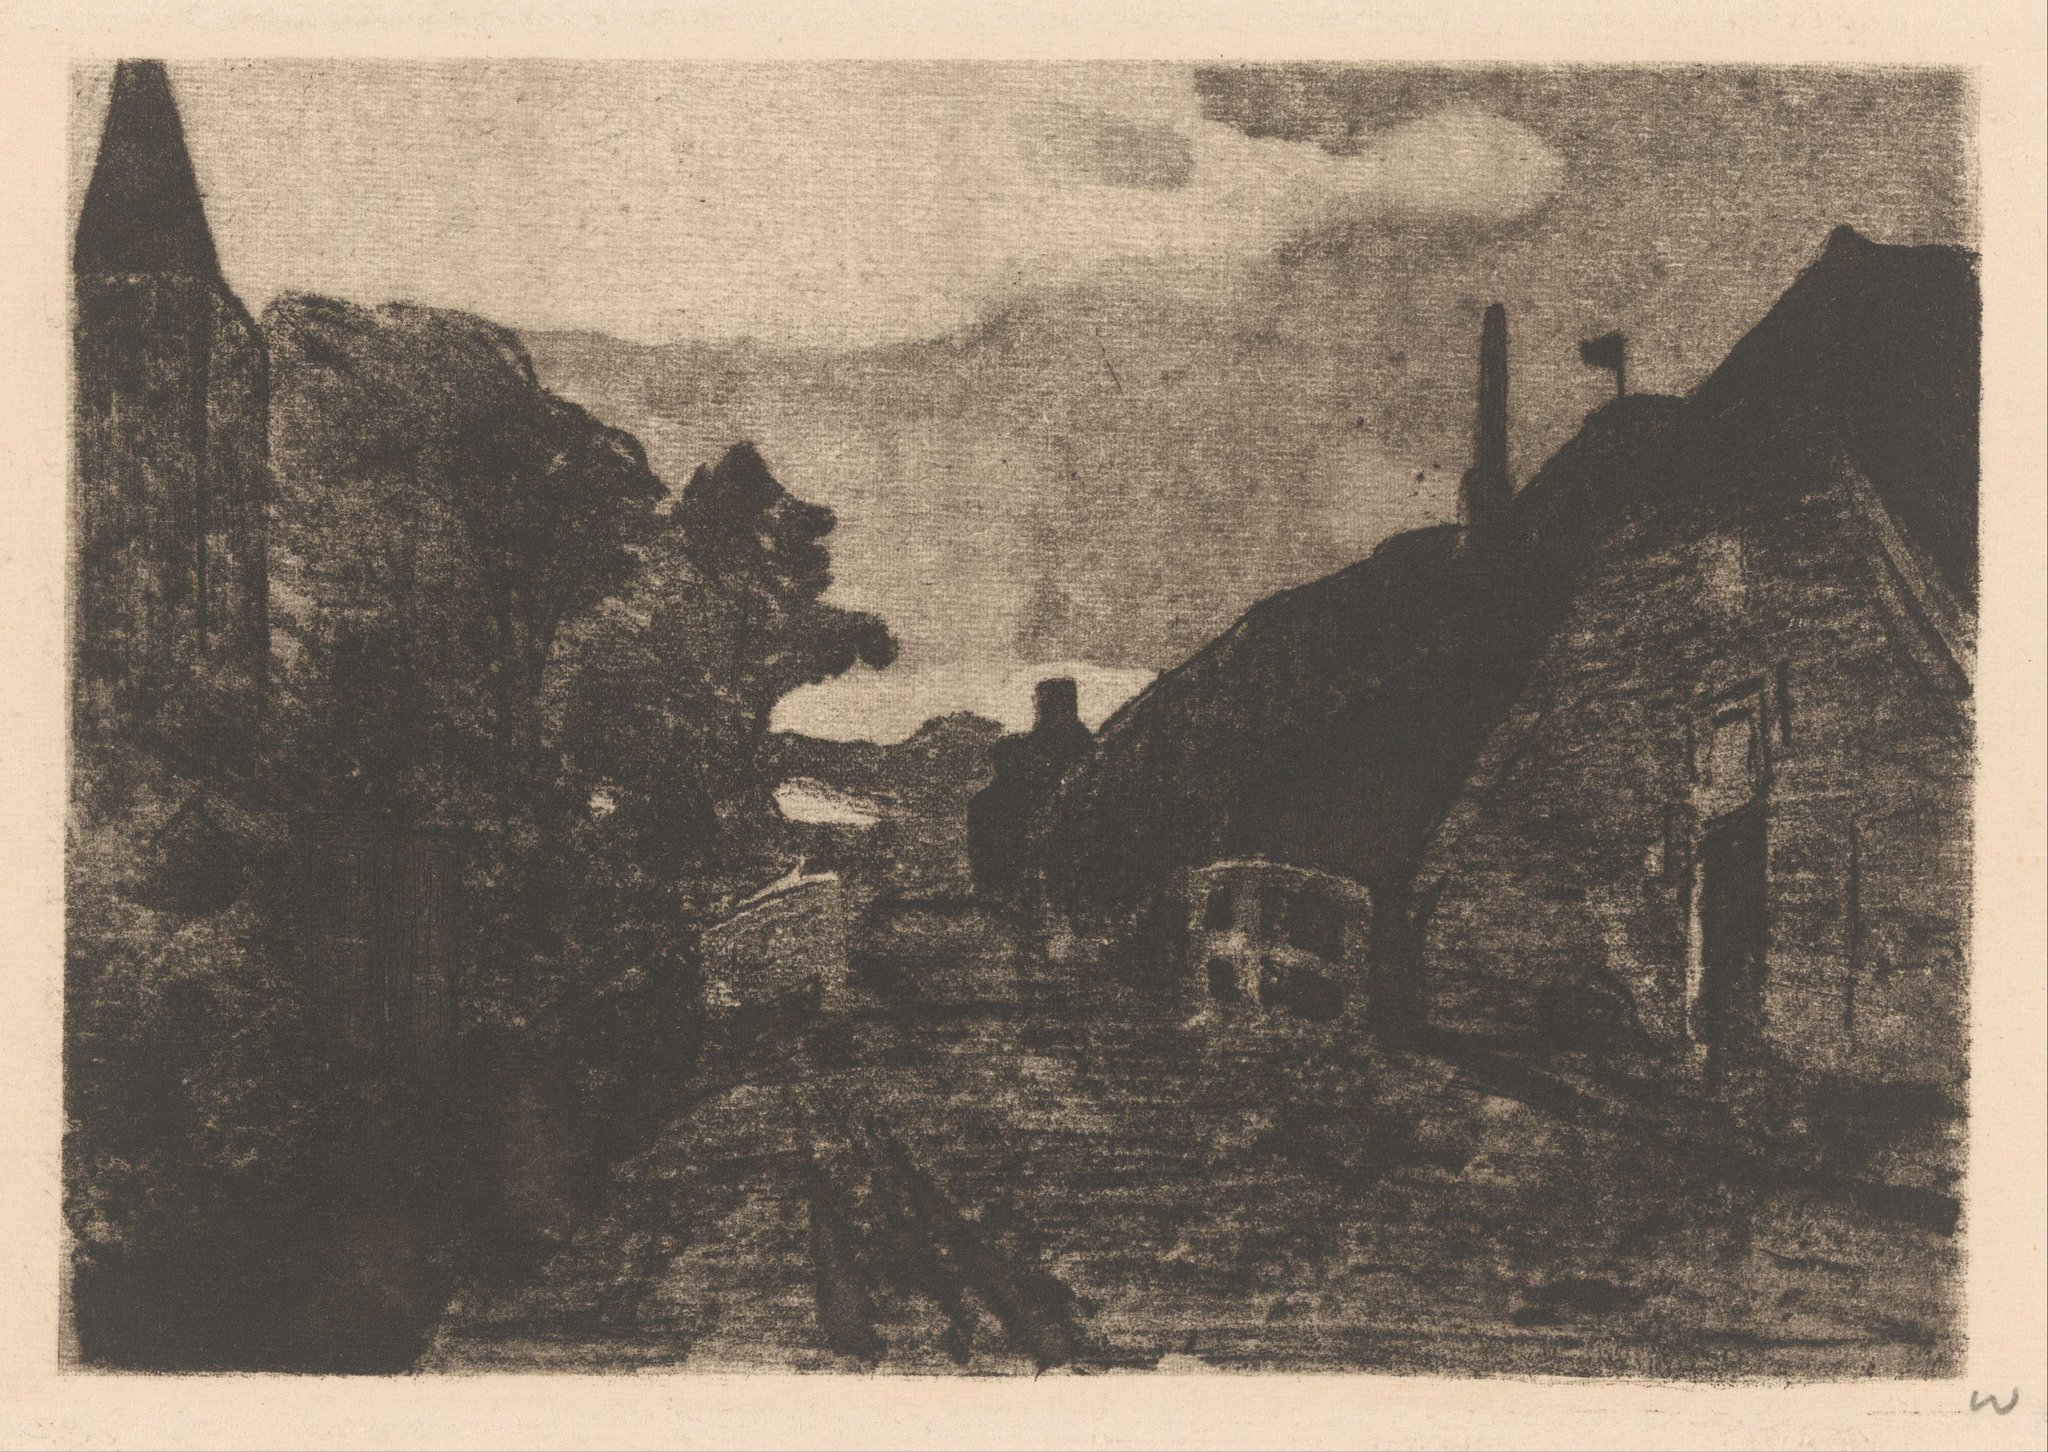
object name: print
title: Dorpsweg in Diepenheim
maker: willem witsen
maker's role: draughtsman, painter, print maker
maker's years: 1860-1923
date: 1888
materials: paper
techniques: etching, intaglio, soft ground etching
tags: tower, clock tower ~ monumental adornment, public road in village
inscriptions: watermark, monogram: ‘W’